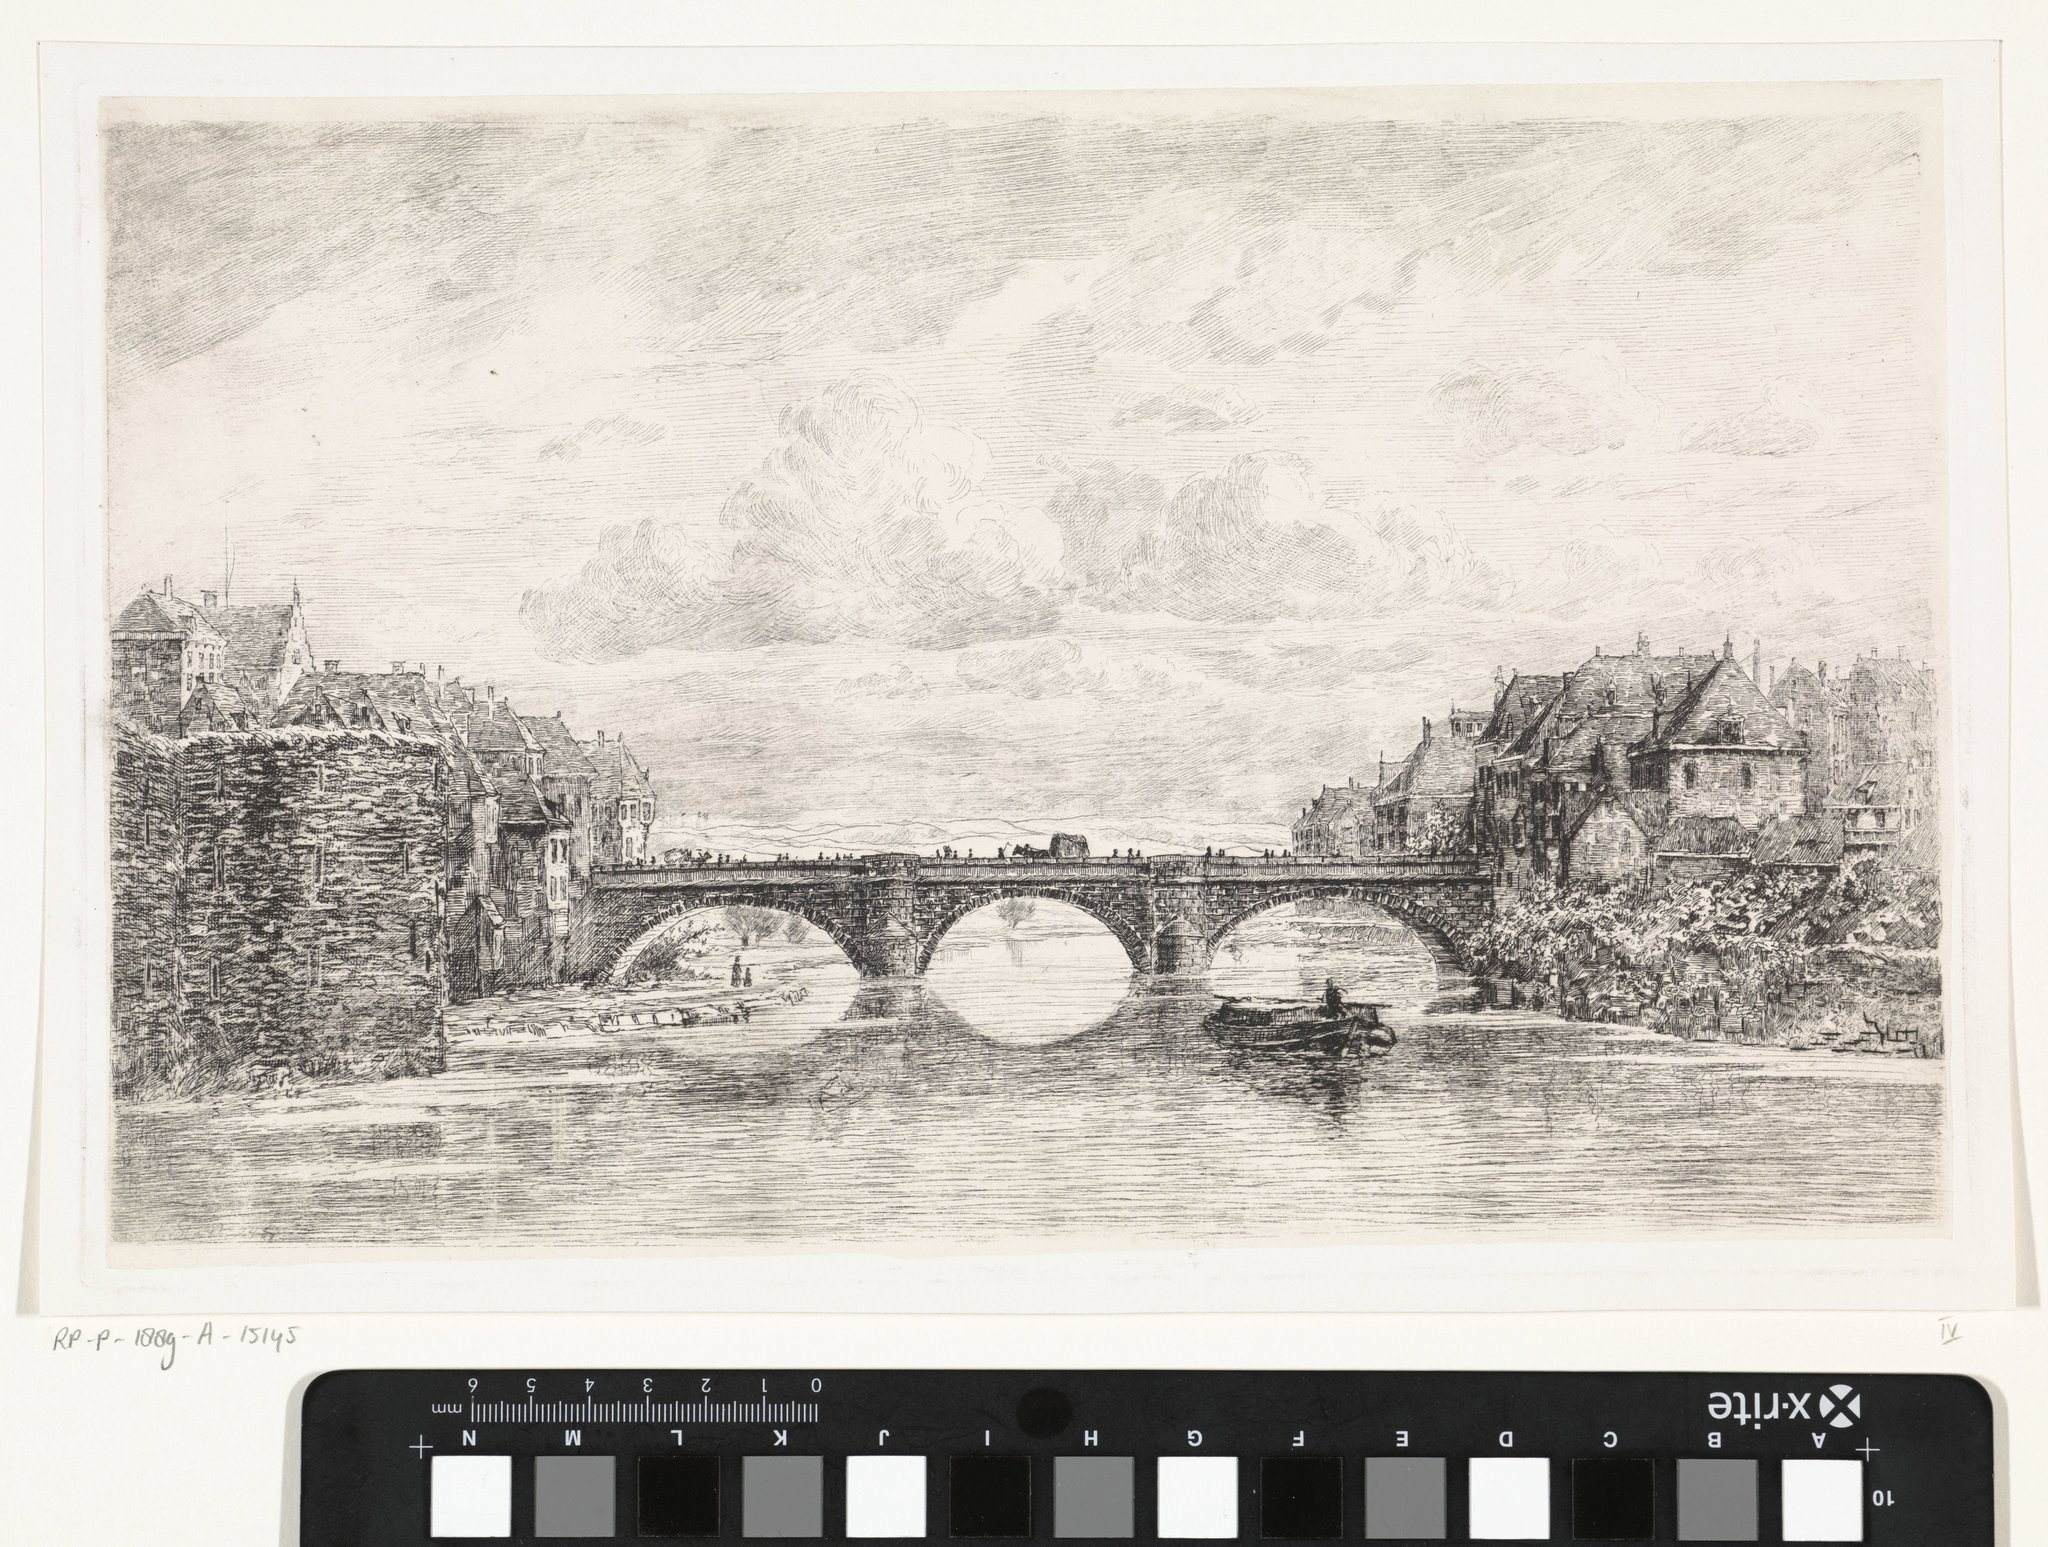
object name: print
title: Brug over de Fulda te Kassel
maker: elias stark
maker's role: draughtsman, print maker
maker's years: 1849-1933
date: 1888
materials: paper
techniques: aquatint, etching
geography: kassel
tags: bridge in city across river, canal, etc.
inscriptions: collector's mark: Lugt 2228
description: De brug over de rivier de Fulda te Kassel.